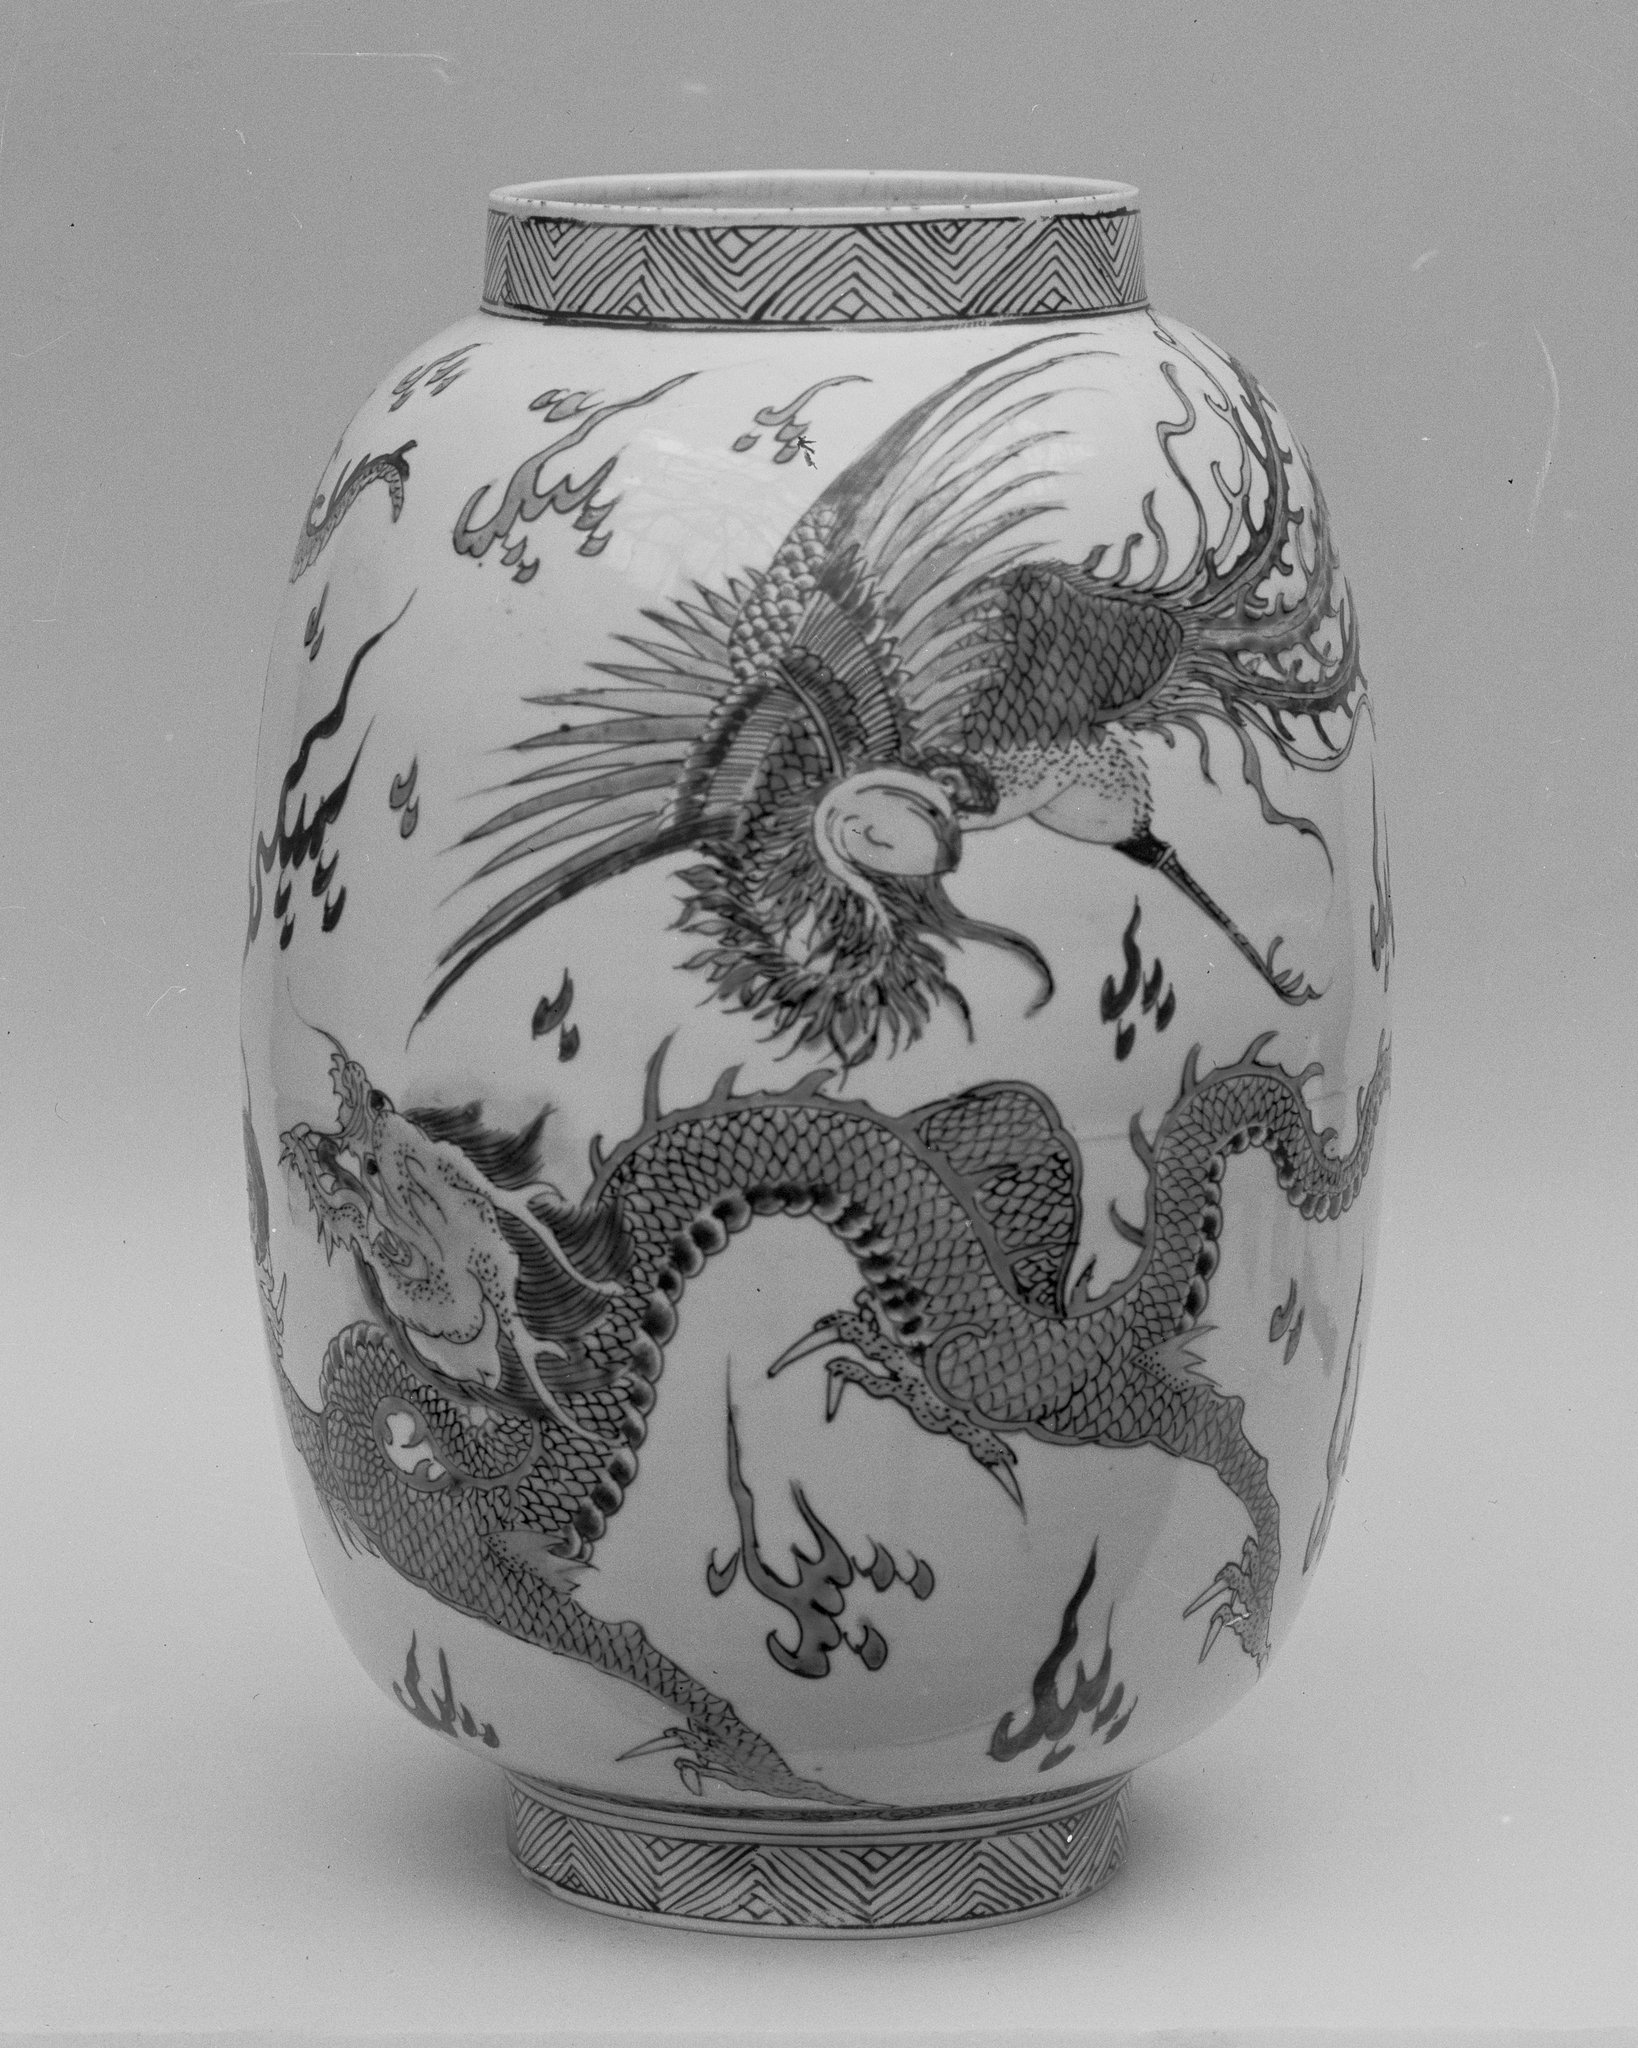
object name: lamp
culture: chinese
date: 1662-1722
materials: enamel, porcelain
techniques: overglaze, painting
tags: dragons